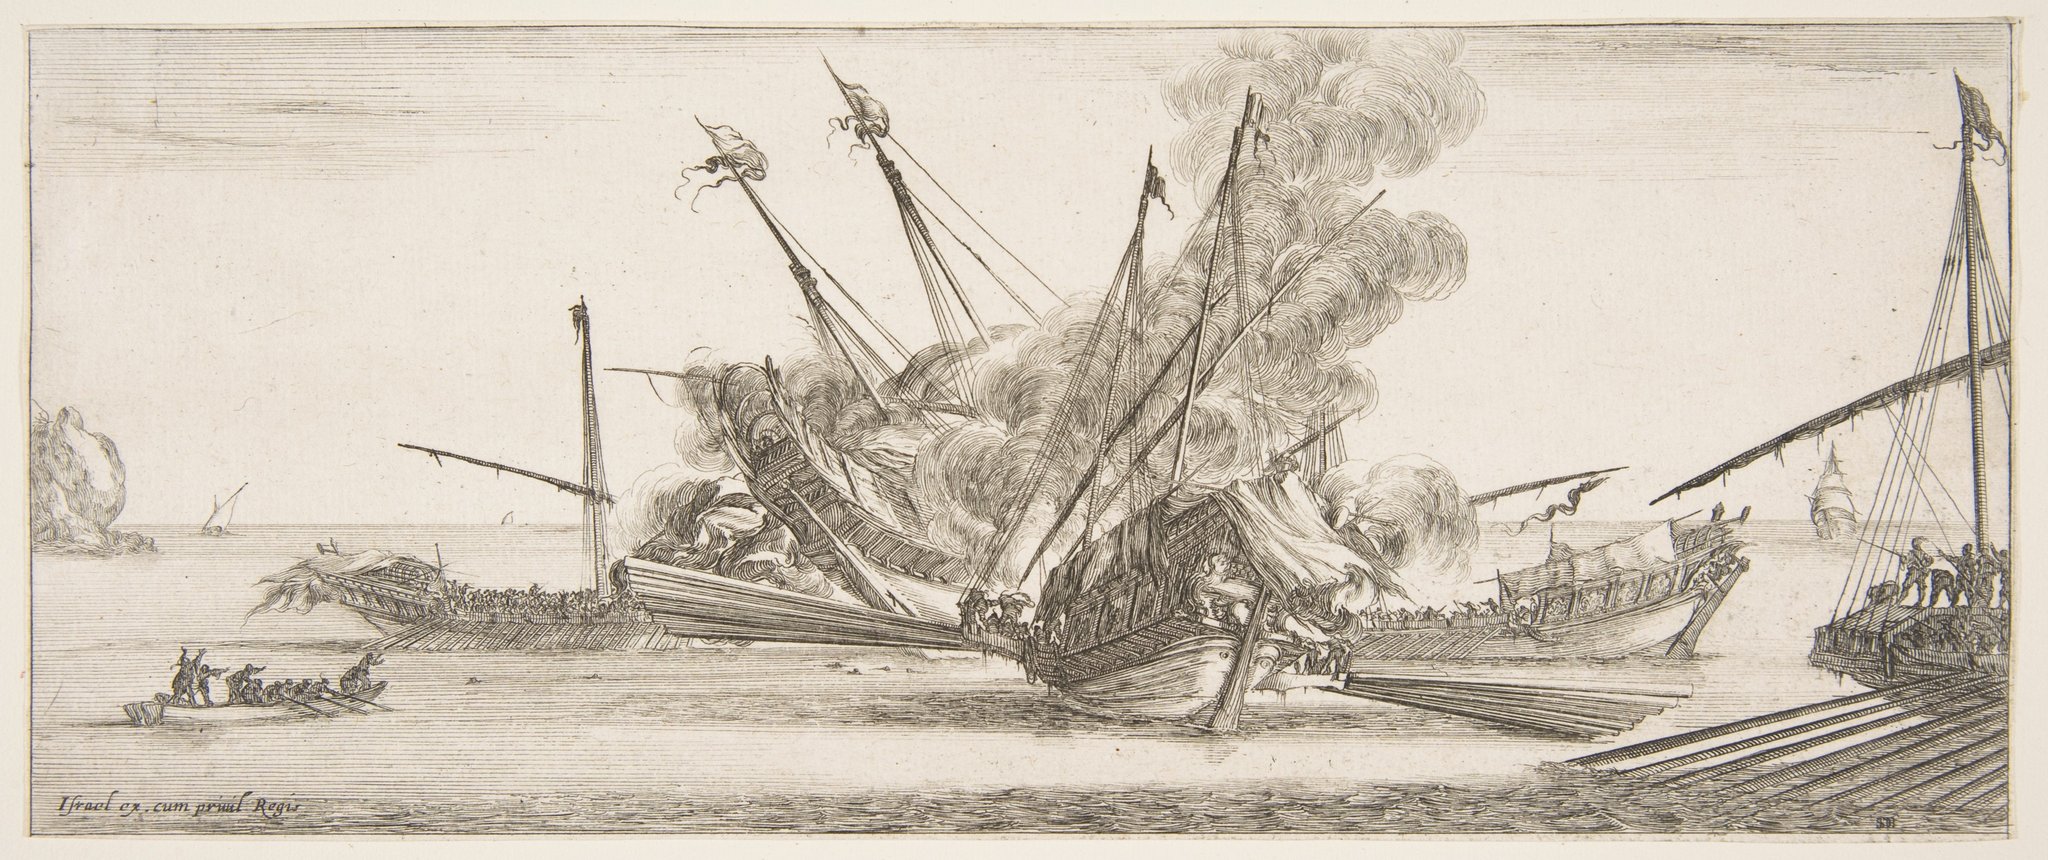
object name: print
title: Naval combat, a ship at center, seen from behind, firing at four enemy ships, another ship entering from the right, a rowboat with nine people to left, from "Peace and War" (Divers desseins tant pour la paix que pour la guerre)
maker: stefano della bella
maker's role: artist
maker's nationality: italian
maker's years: 1610-1664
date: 1641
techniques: etching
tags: wars,boats,ships